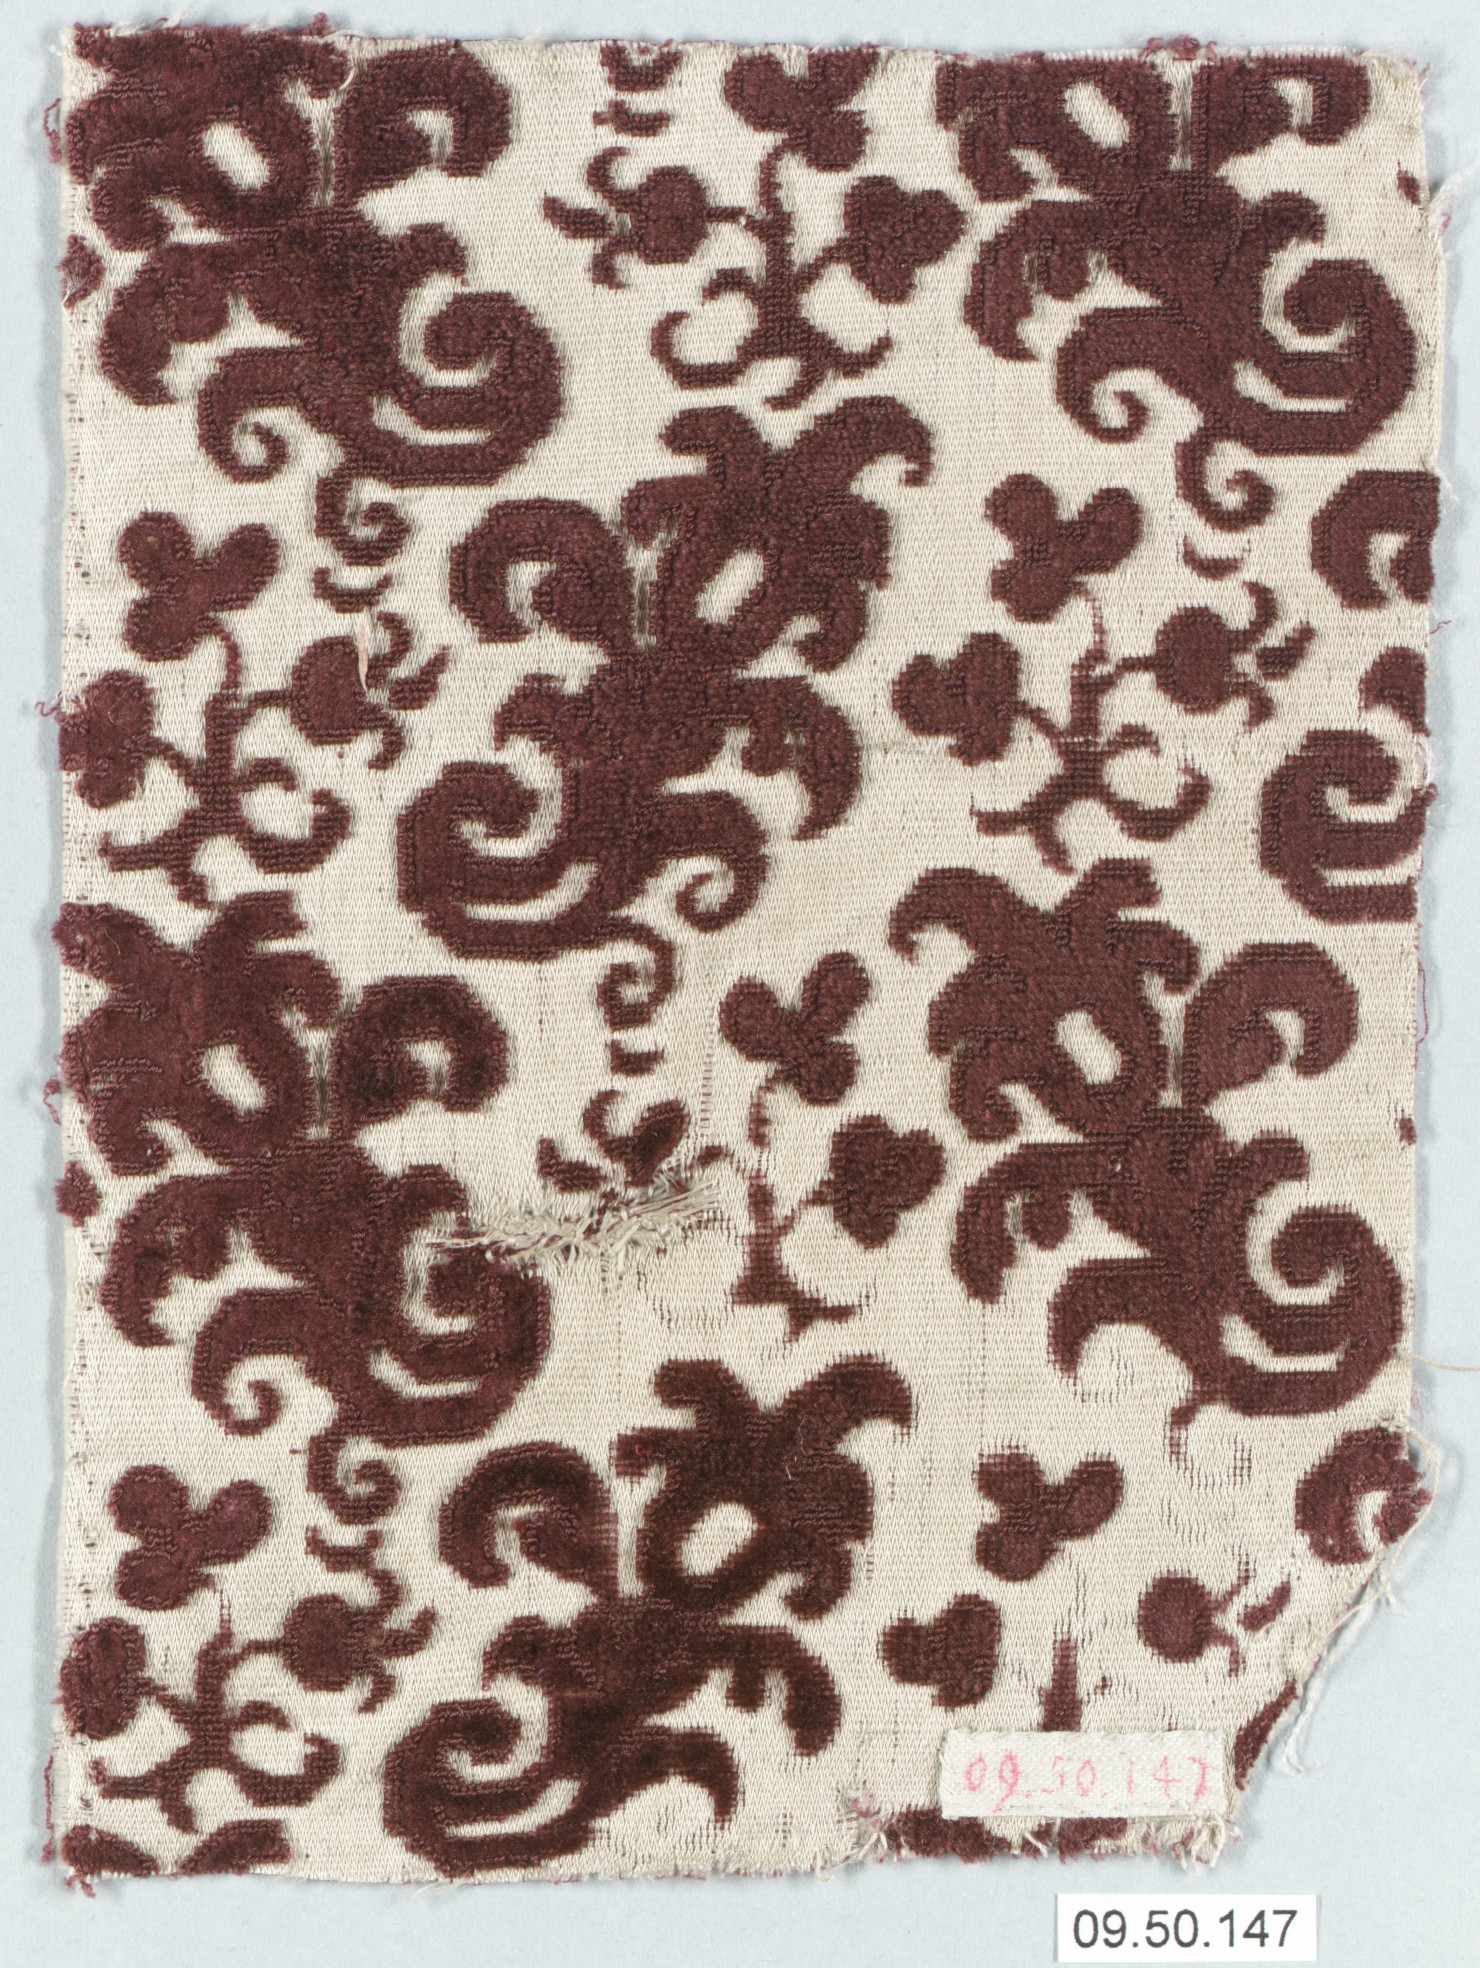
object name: piece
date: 1501-1600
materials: silk